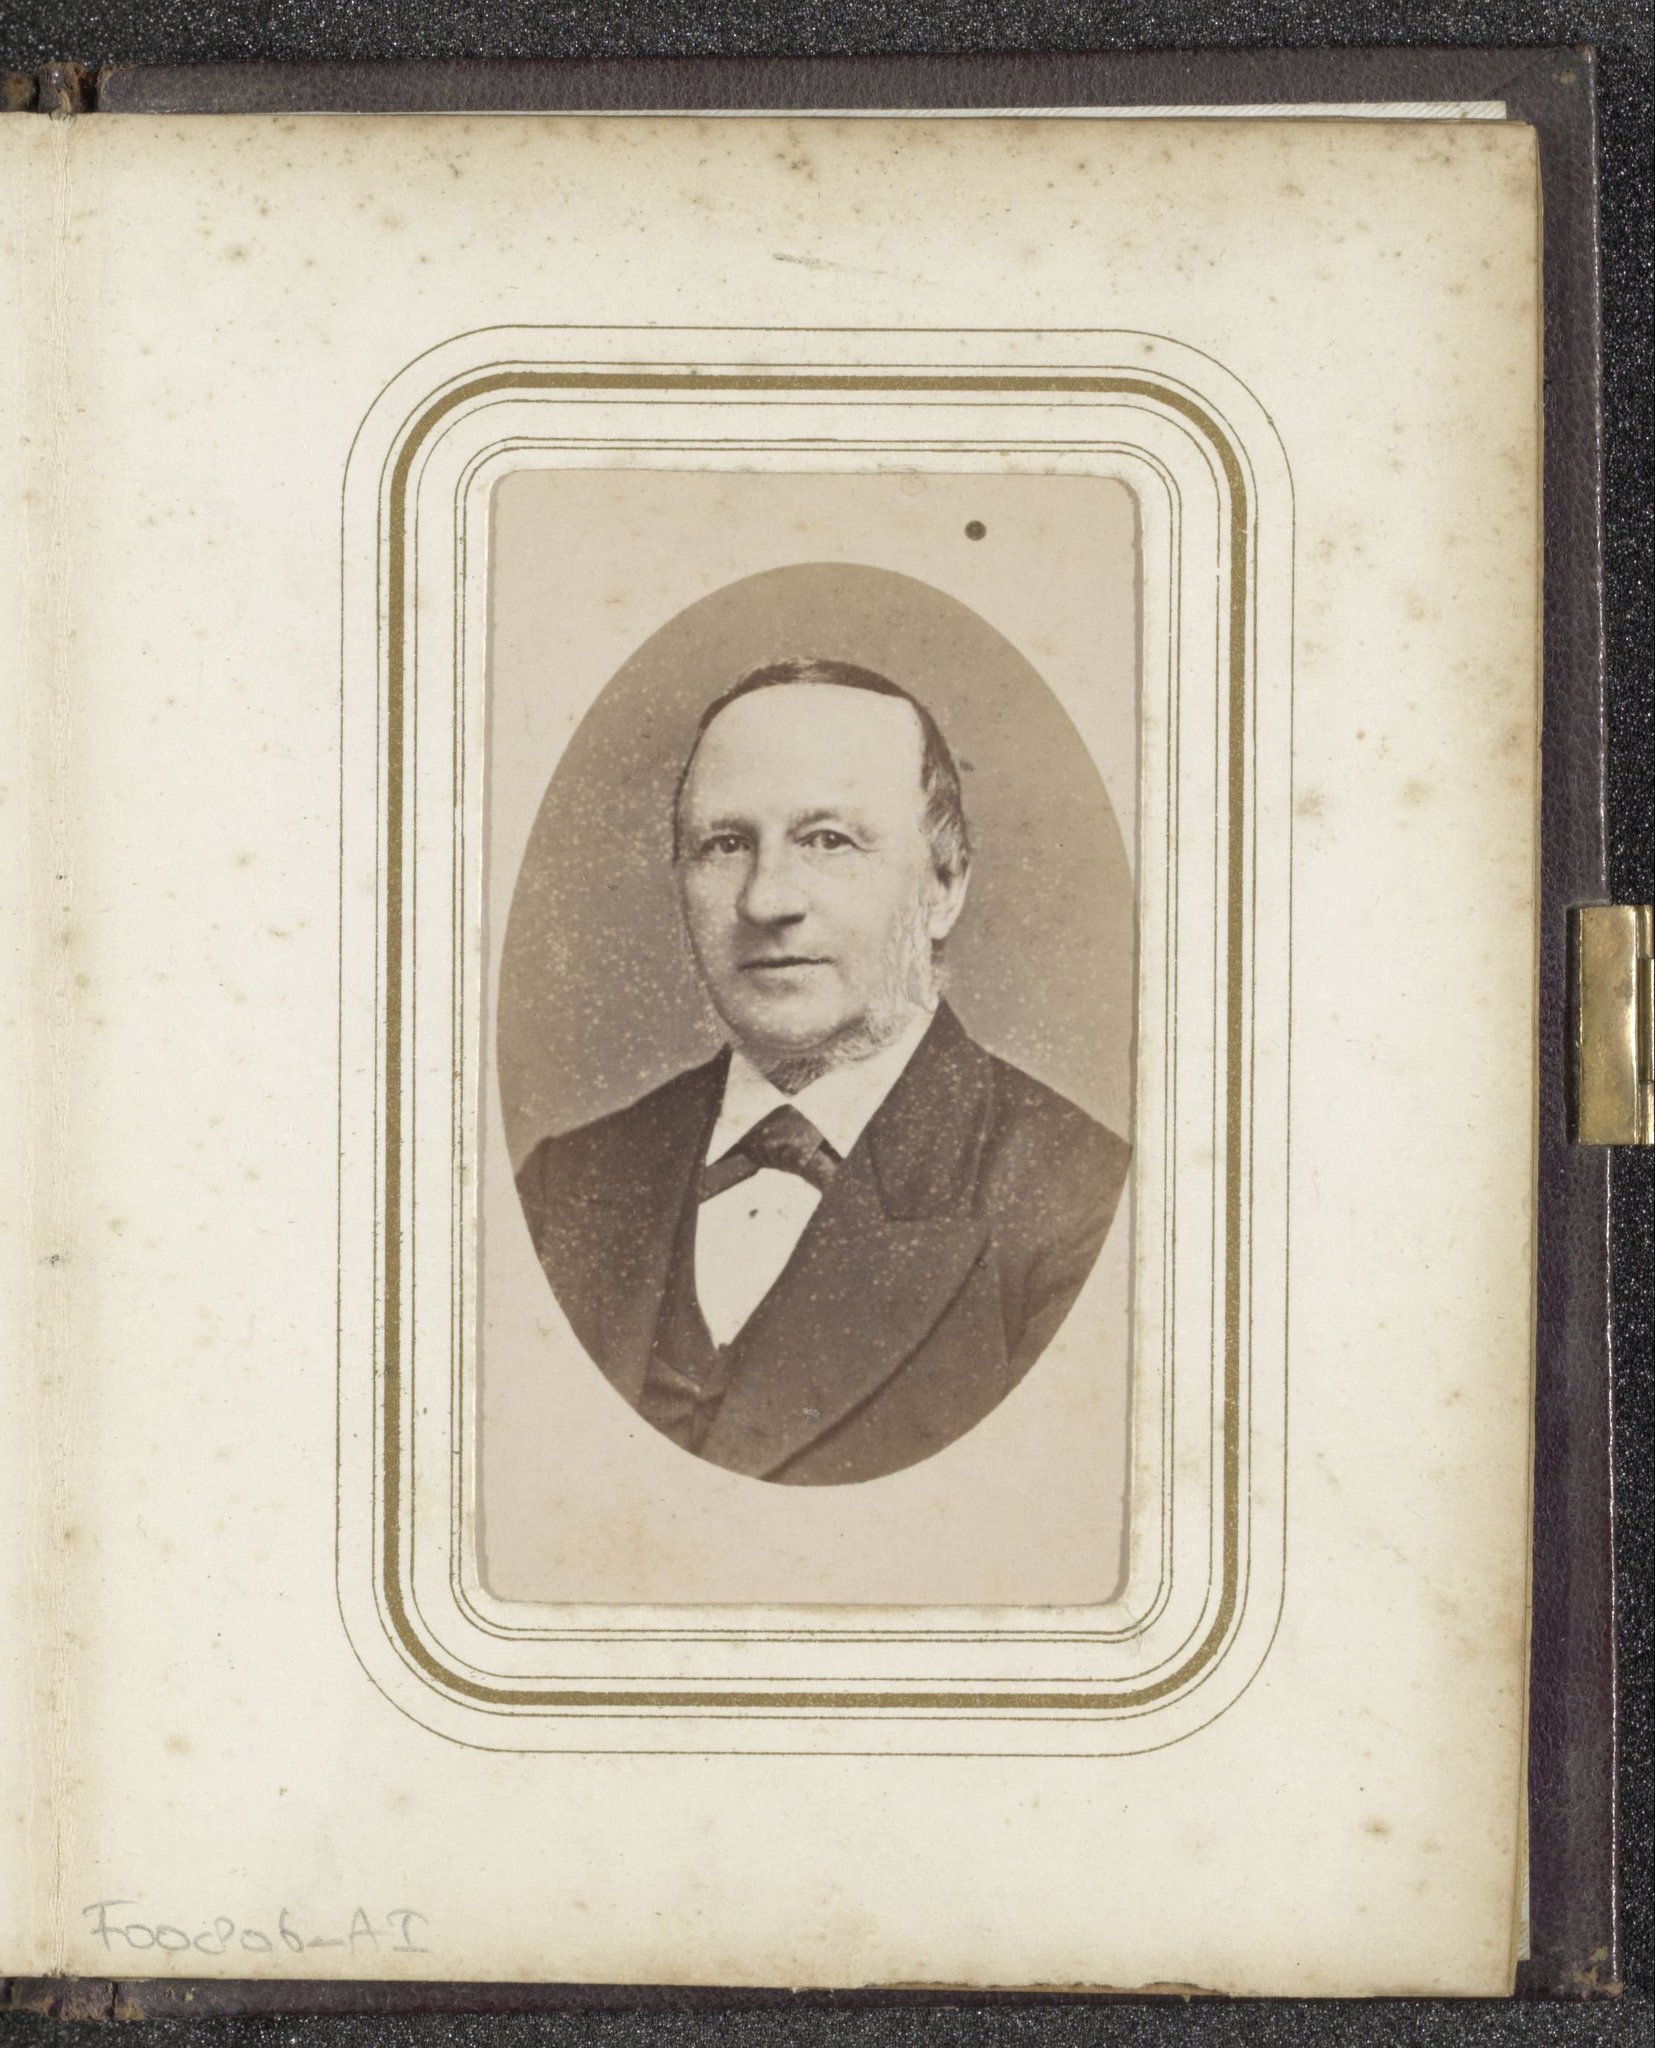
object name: carte de visite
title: Portret van een man met bakkebaarden in een jas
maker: a. böeseken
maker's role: fotograaf, lithograaf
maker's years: 1834-1919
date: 1873-1889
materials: cardboard, paper, photographic support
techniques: albumen print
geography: rotterdam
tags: sideburns, historical persons, neck-gear ~ clothing, clothing for the upper part of the body, baldness, rotterdam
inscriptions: address: ‘Rotterdam’, address: ‘Hoogstraat schuins over de Vlasmarkt No. 343’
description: Onderdeel van Fotoalbum met 36 cartes-de-visite van Nederlandse personen.